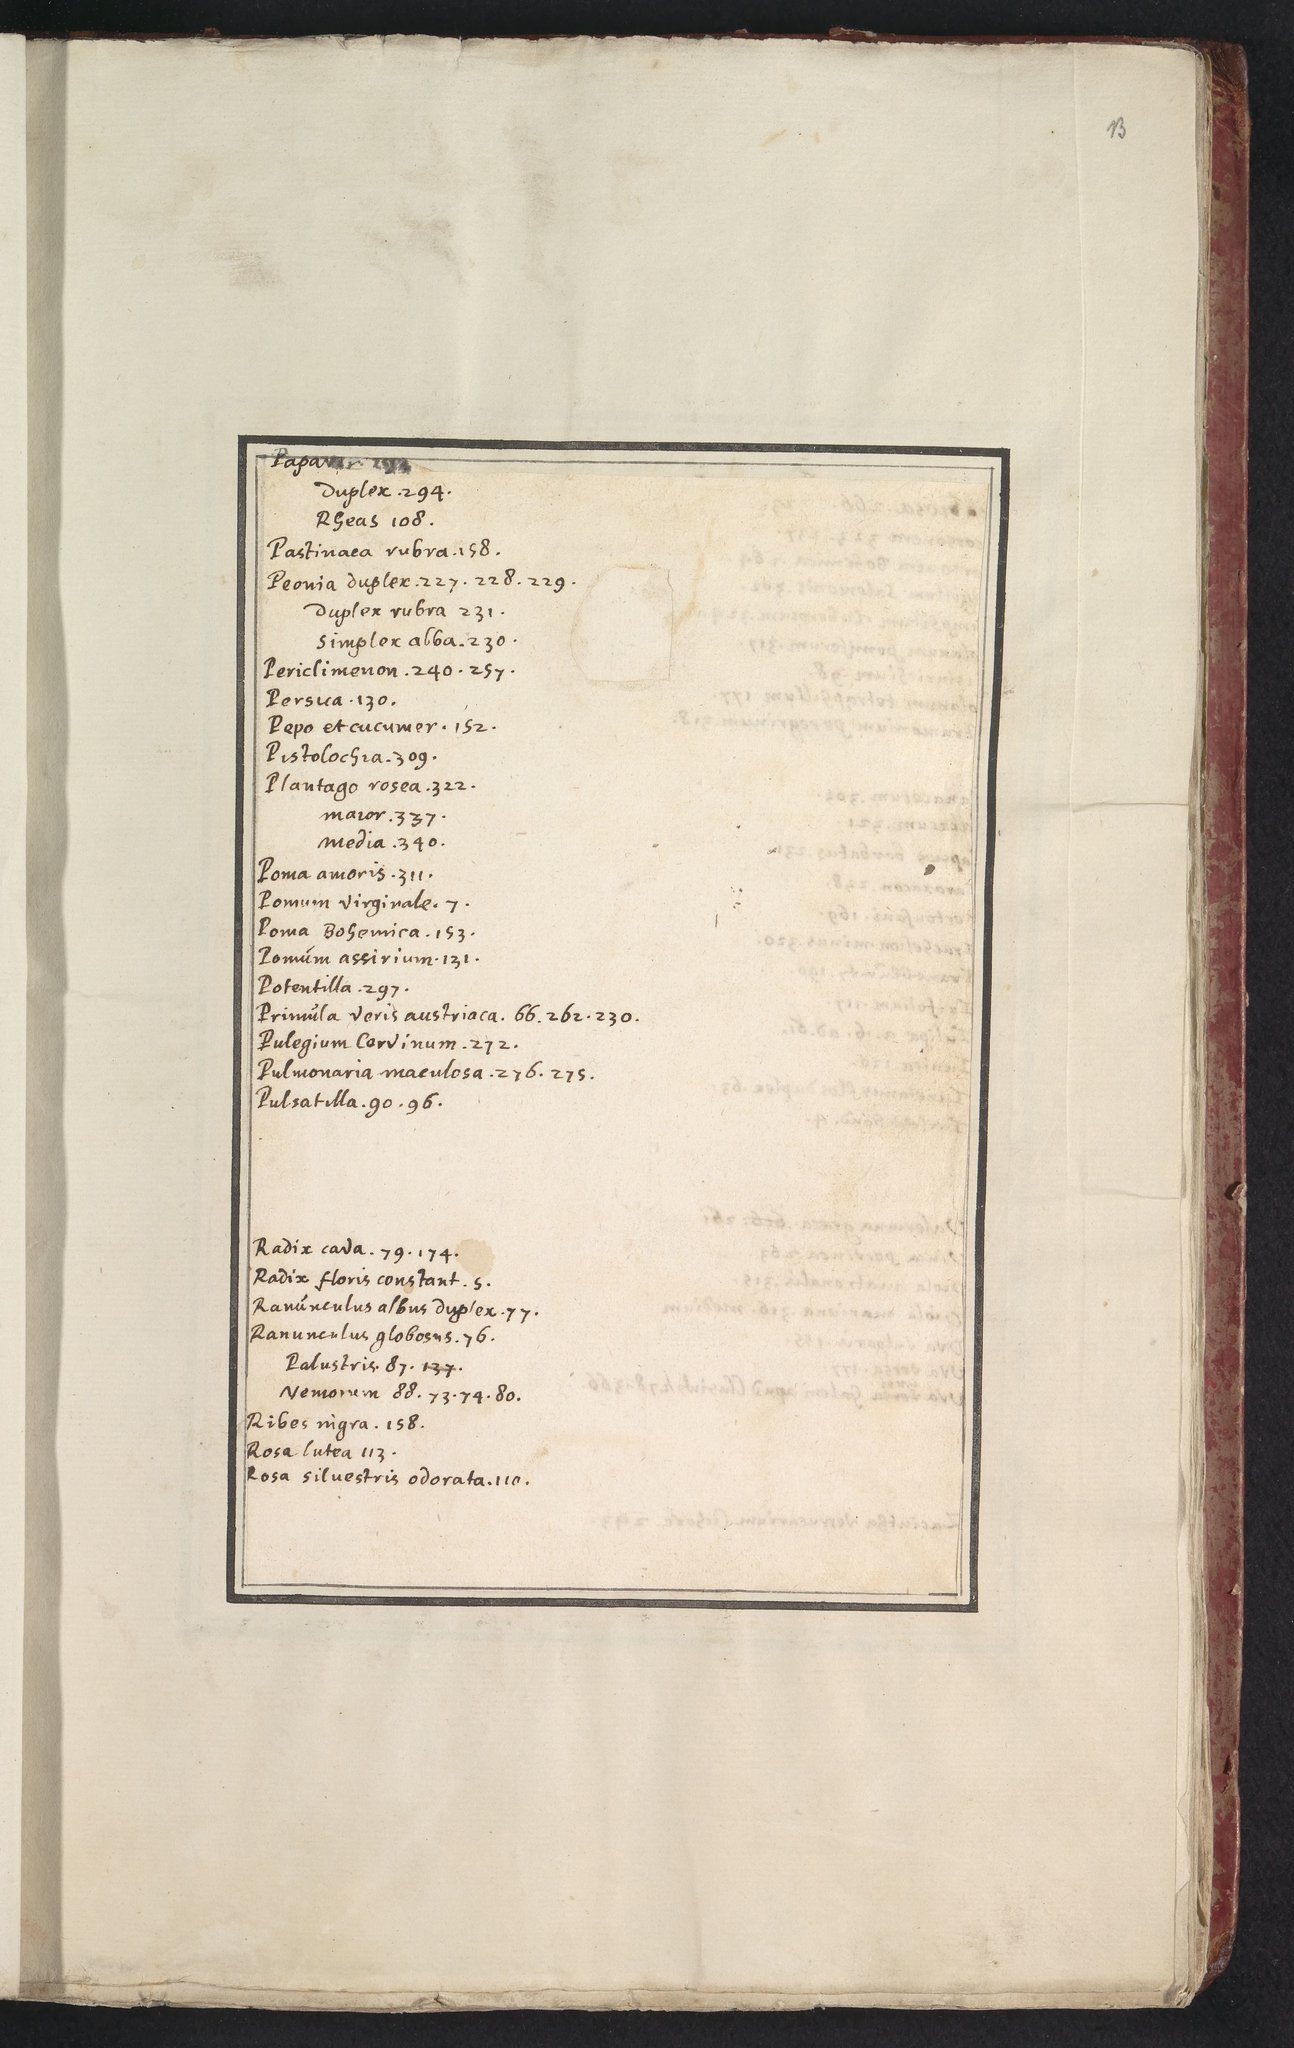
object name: manuscript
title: Alfabetische lijst van de Latijnse namen van de afgebeelde bloemen P-R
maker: anselmus boëtius de boodt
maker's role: draughtsman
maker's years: 1550-1632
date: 1596-1632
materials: ink, paper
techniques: handwriting, pen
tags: handwriting, written text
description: Originele lijst van de Latijnse namen van de bloemen afgebeeld in de vier delen van de planten. Namen beginnend met P-R. Onderdeel van het eerste album met tekeningen van bloemen. Achtste van twaalf albums met tekeningen van dieren, vogels en planten bekend rond 1600, gemaakt in opdracht van keizer Rudolf II. Met toelichting in Nederlands, Latijn en Frans.